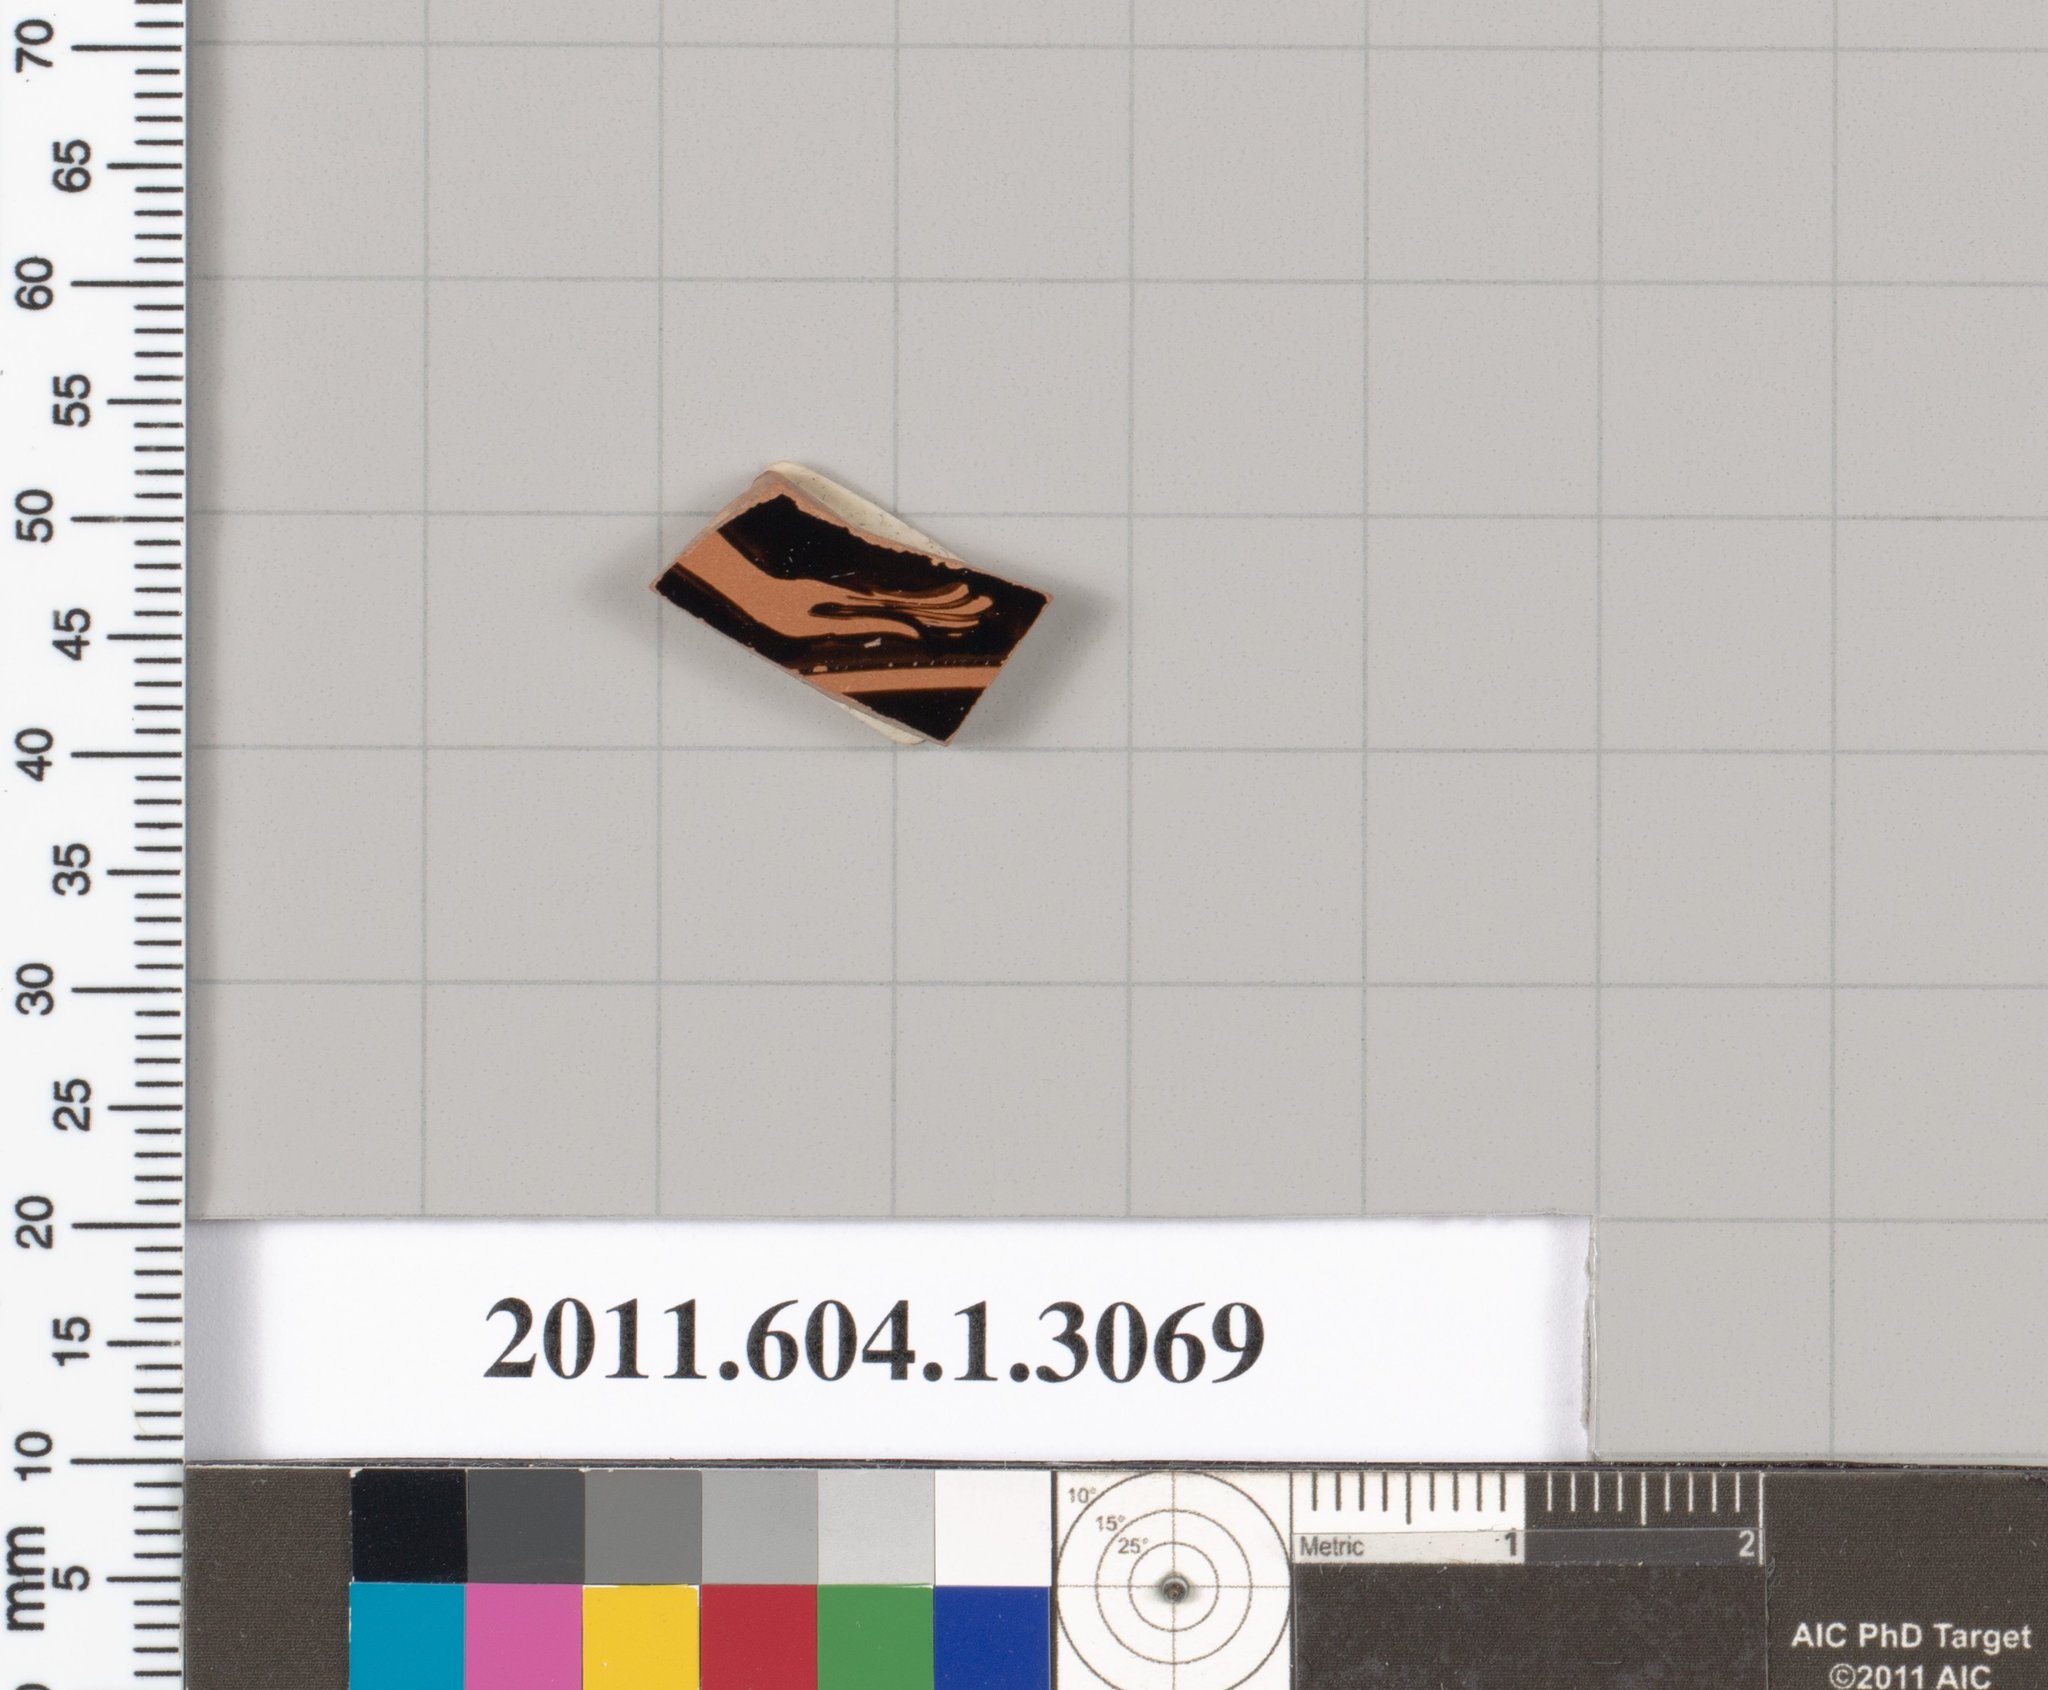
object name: kylix fragment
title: Terracotta fragment of a kylix (drinking cup)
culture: greek, attic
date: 500-480 BCE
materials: terracotta